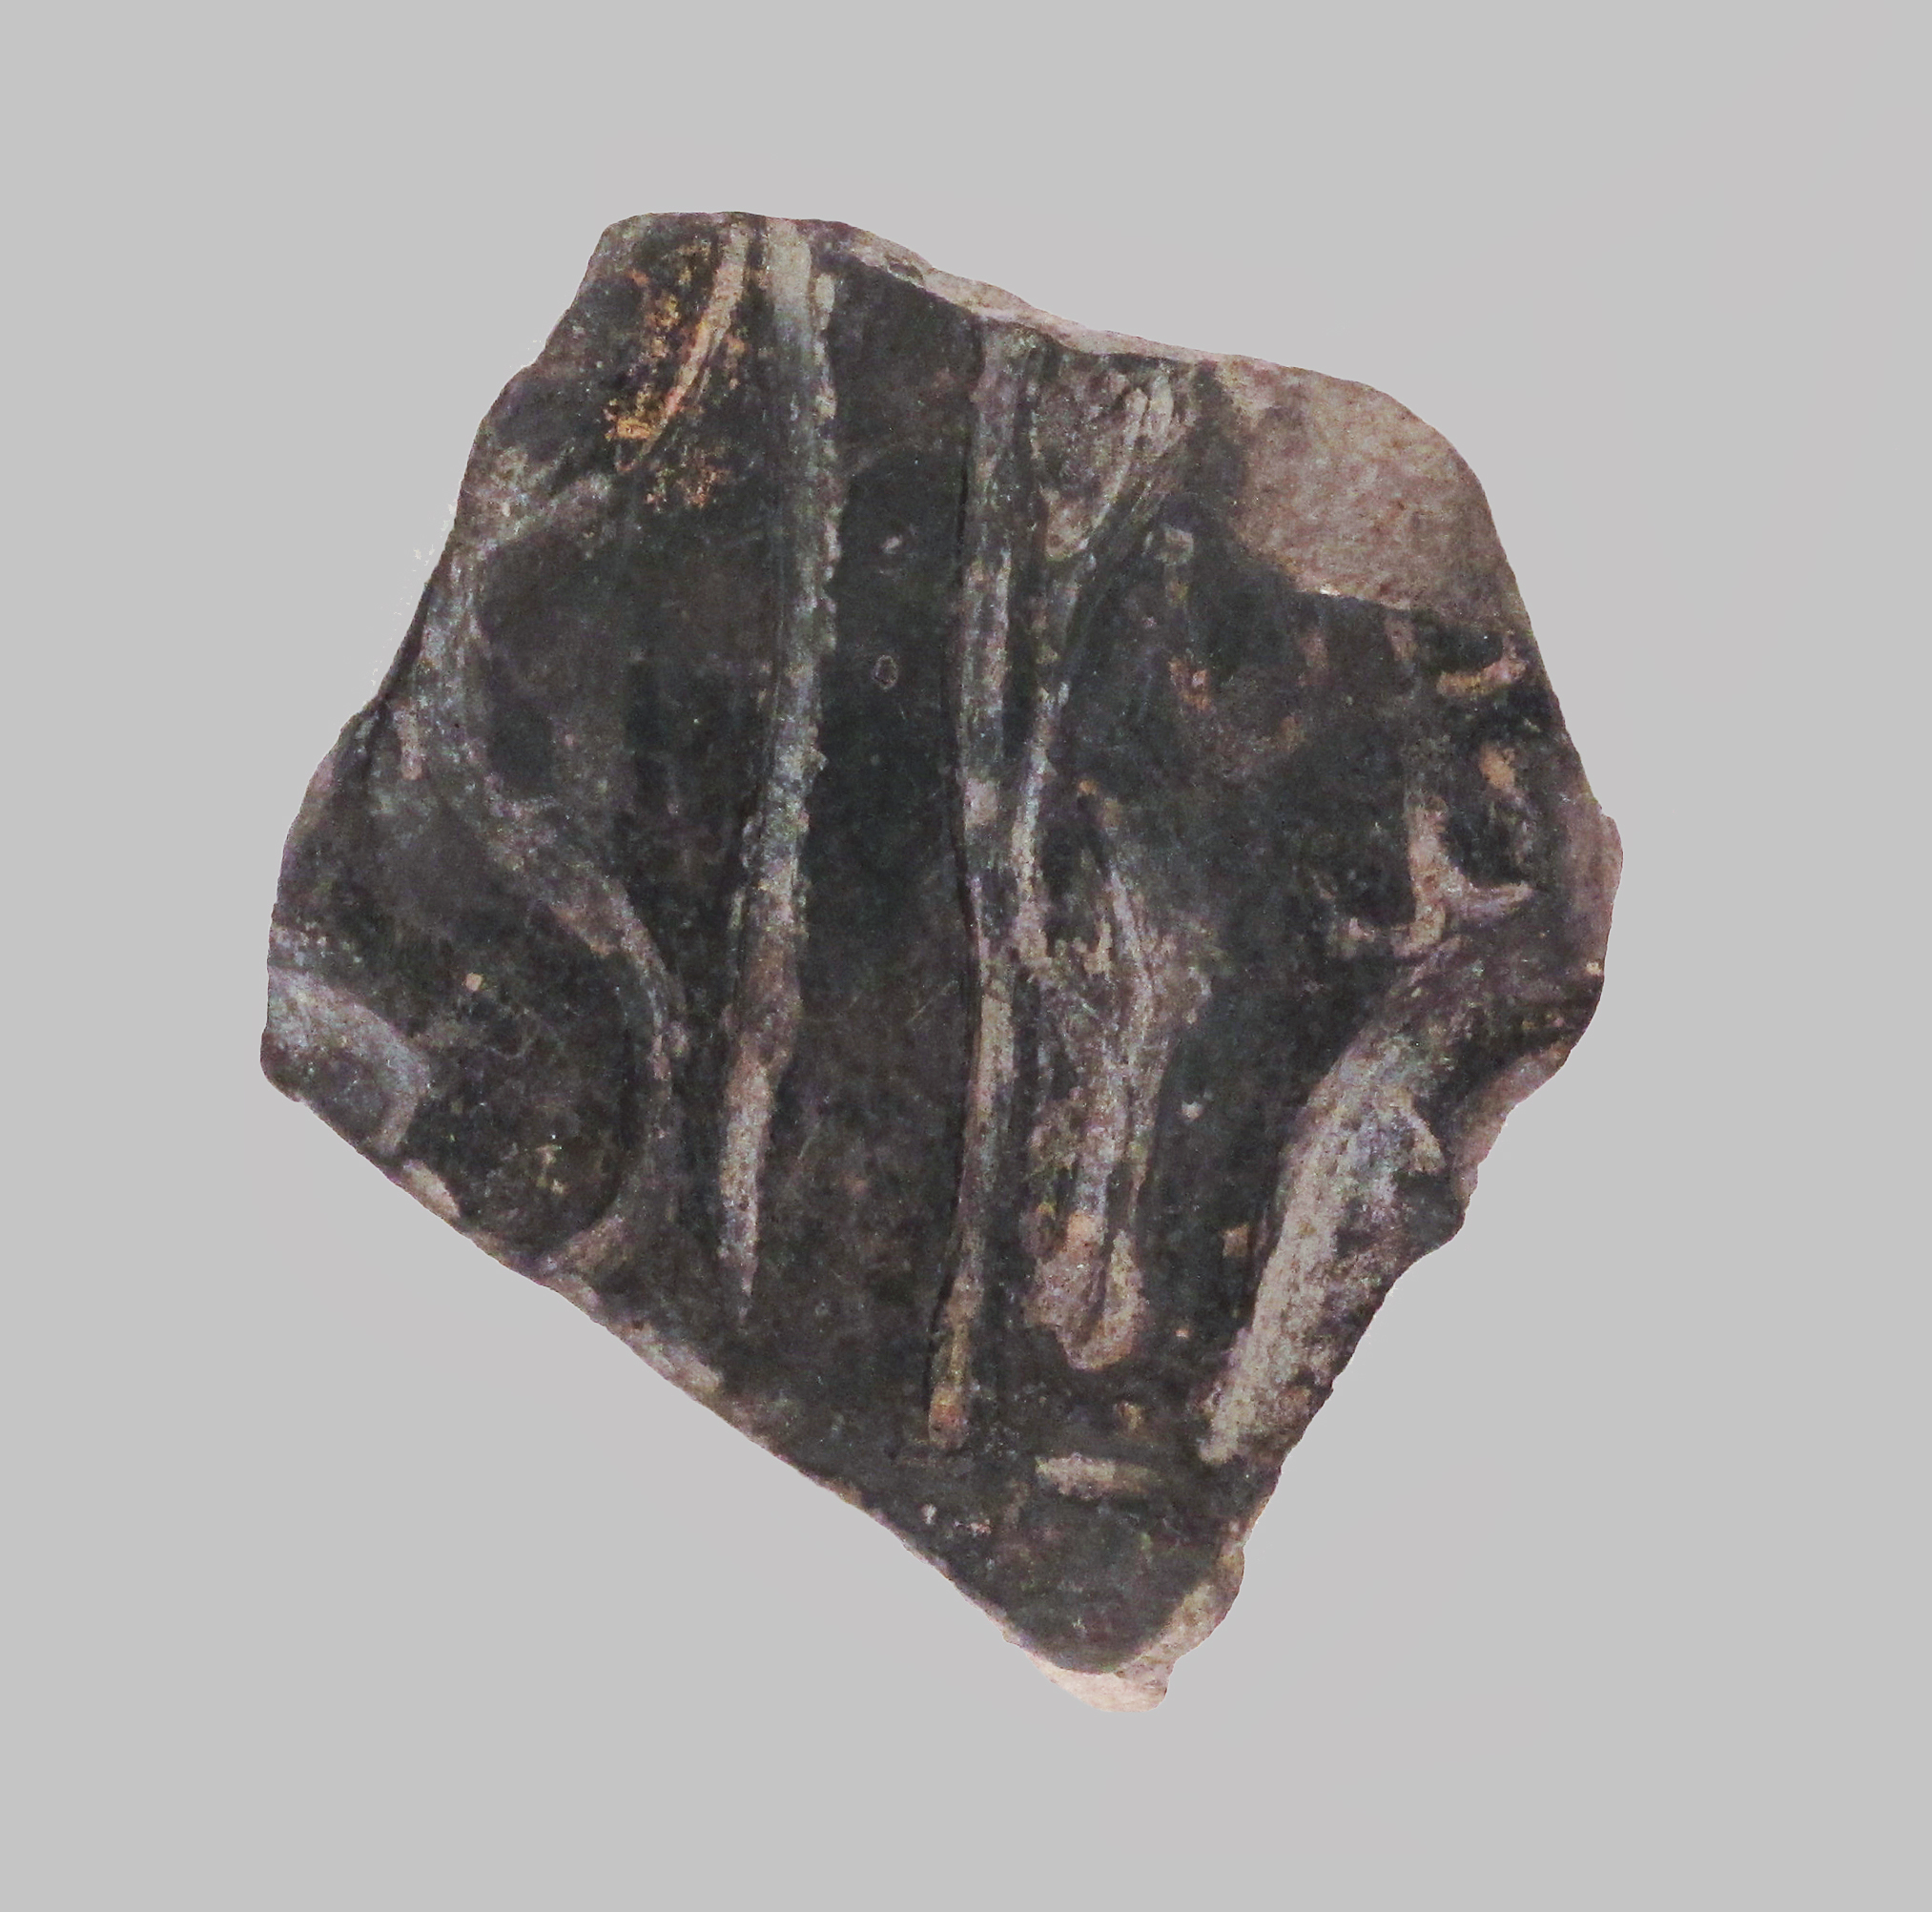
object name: vase fragment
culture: etruscan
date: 575-550 BCE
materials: terracotta